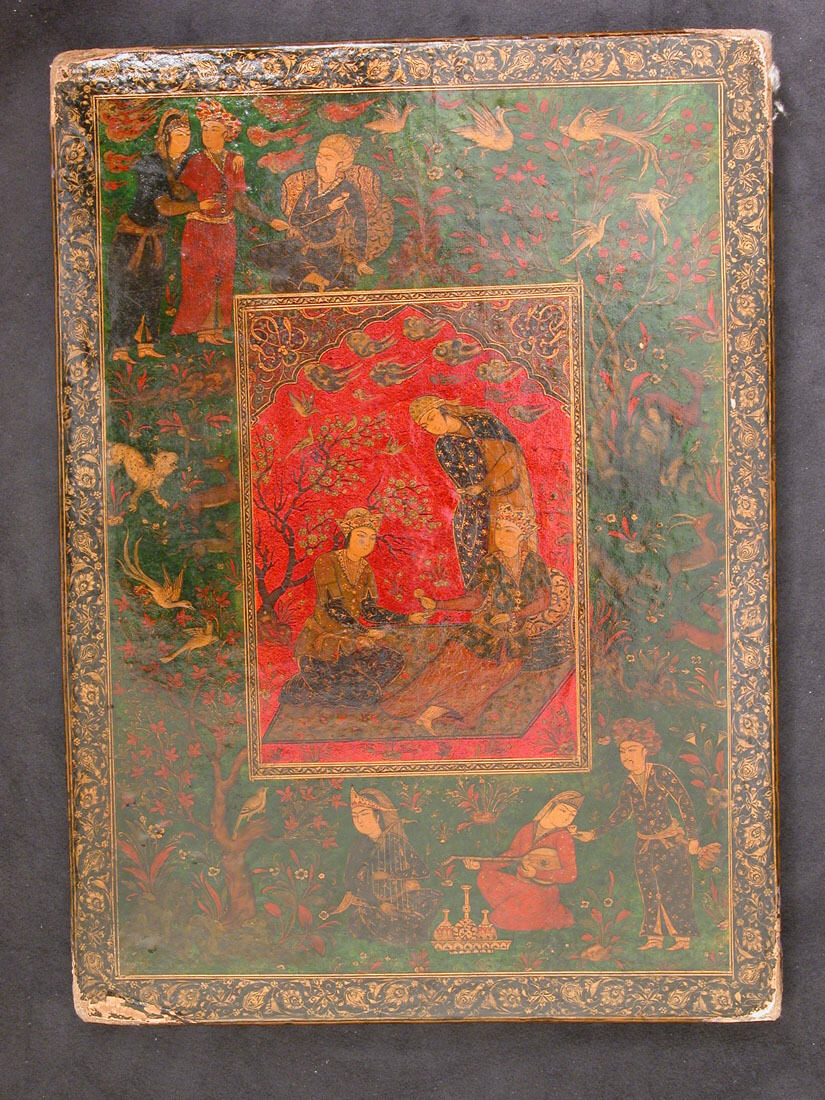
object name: mirror case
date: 1867-1900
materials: paper, varnish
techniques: gilding, lacquer, painting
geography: iran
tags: birds,men,women